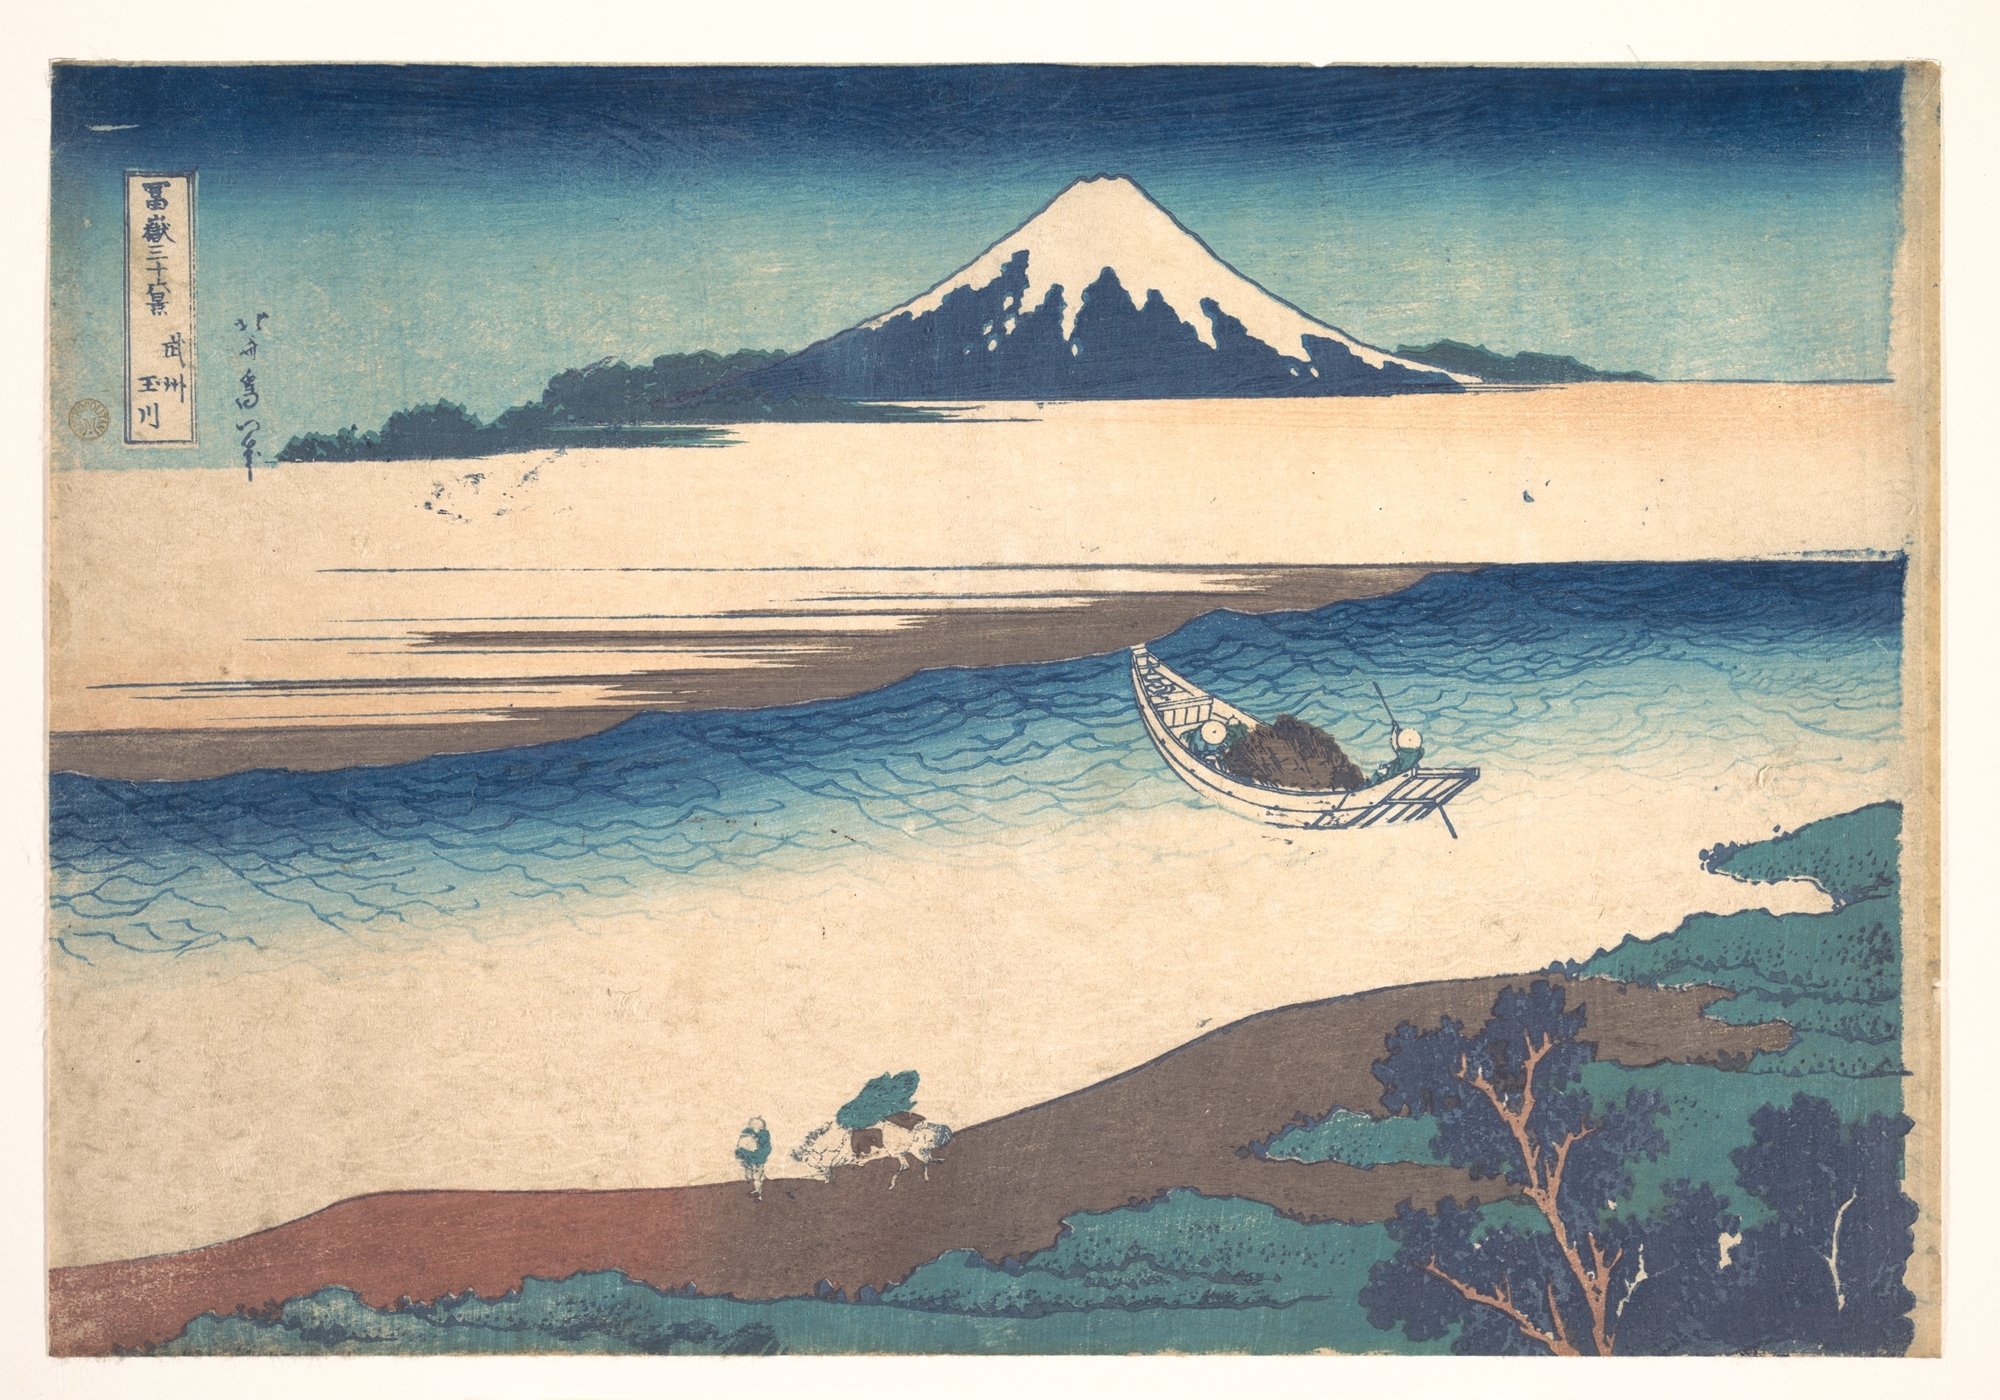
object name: woodblock print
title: Tama River in Musashi Province (Bushū Tamagawa), from the series Thirty-six Views of Mount Fuji (Fugaku sanjūrokkei)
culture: japanese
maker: katsushika hokusai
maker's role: artist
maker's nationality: japanese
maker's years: 1760-1849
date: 1830-1832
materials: ink, paper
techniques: woodblock print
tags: rivers,mountains,landscapes,trees,boats